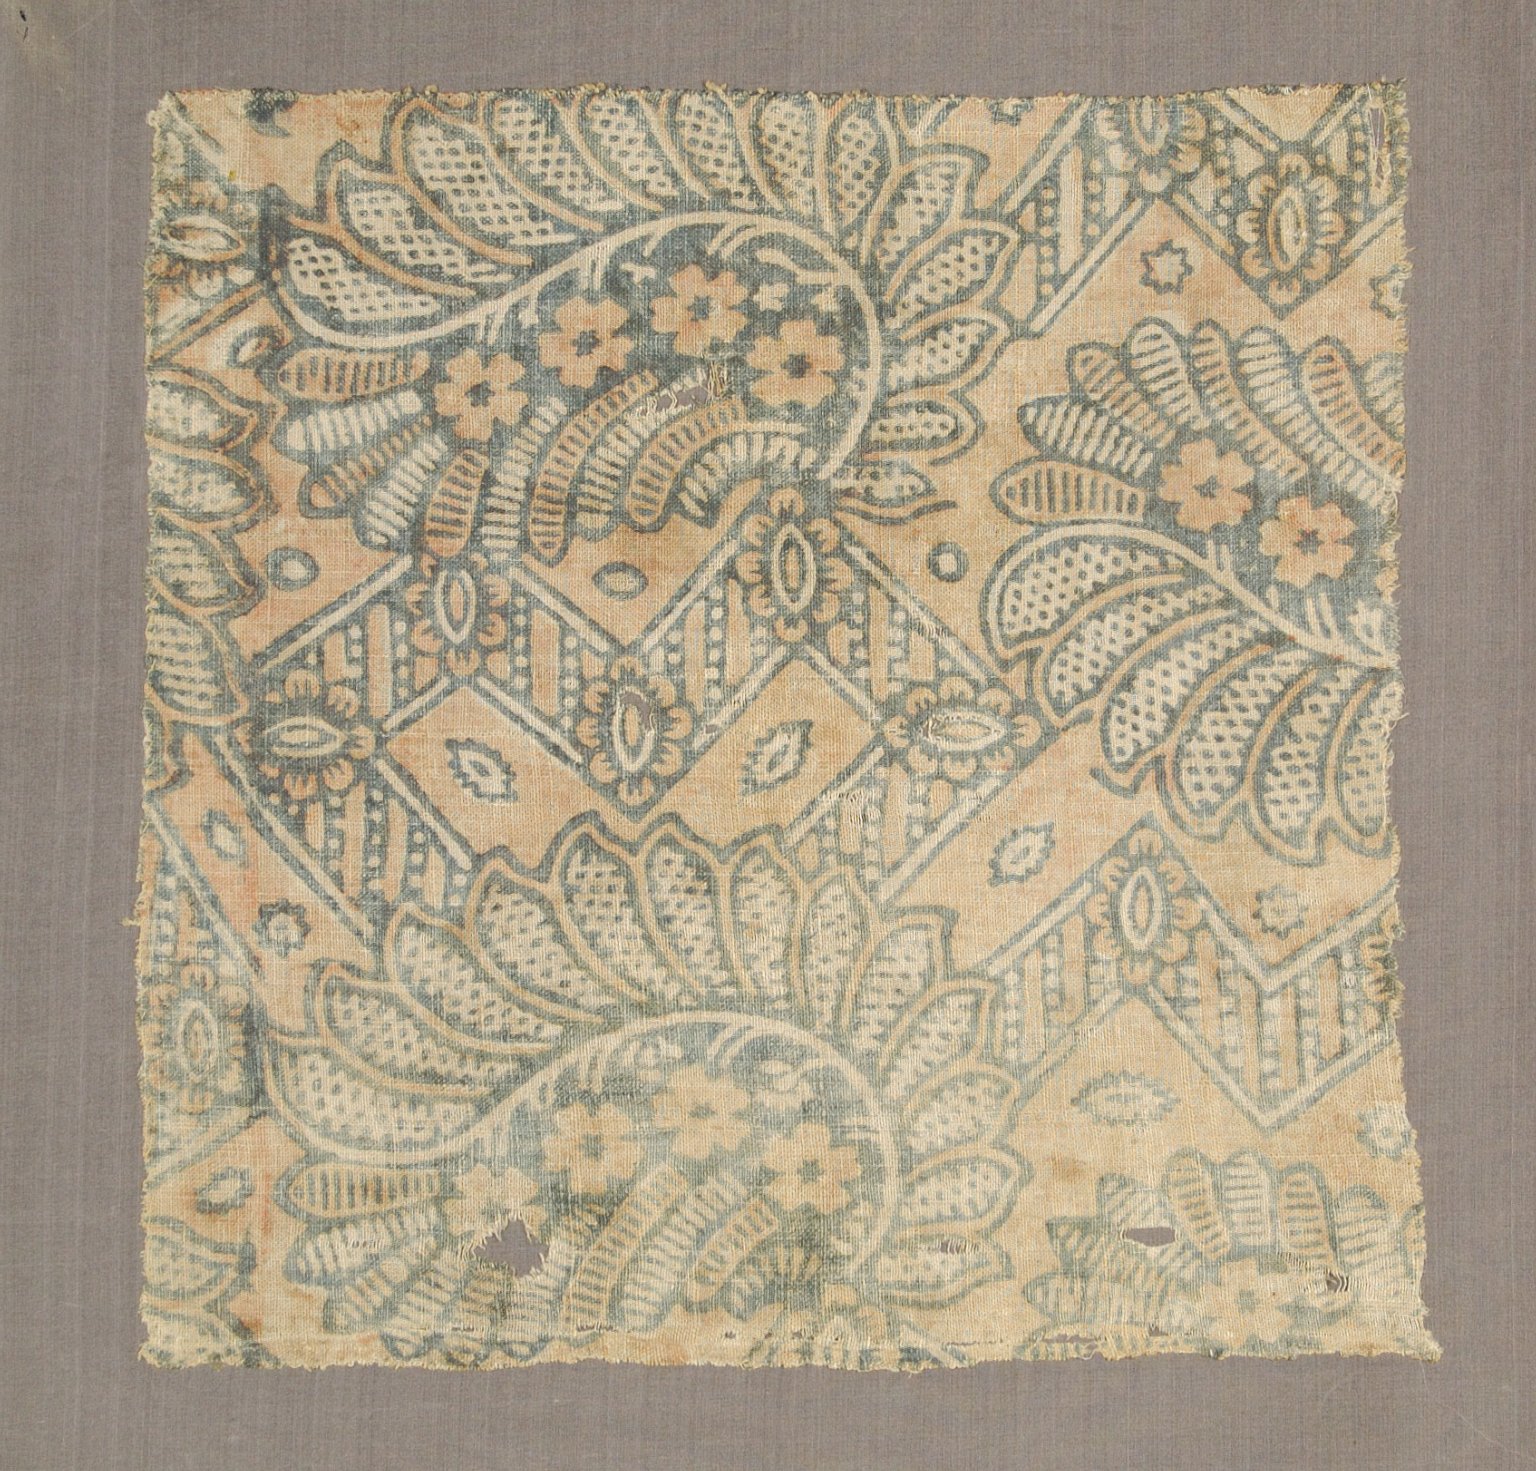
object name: textile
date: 1700-1899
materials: linen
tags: flowers